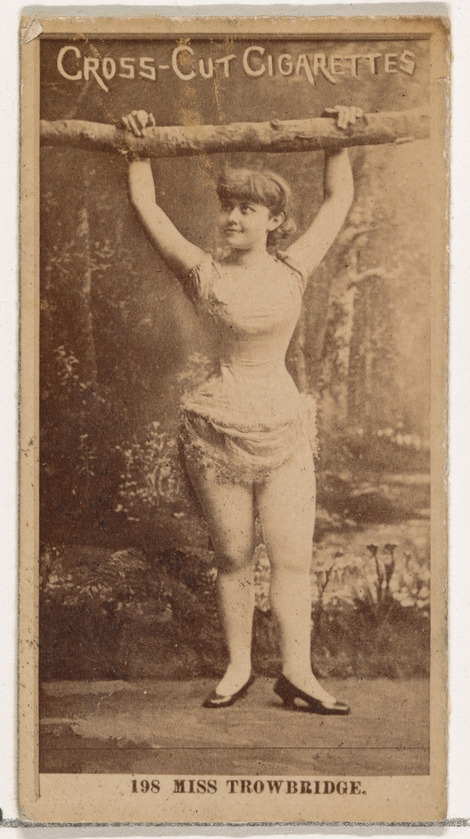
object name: print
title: Card Number 198, Miss Trowbridge, from the Actors and Actresses series (N145-2) issued by Duke Sons & Co. to promote Cross Cut Cigarettes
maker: w. duke, sons & co.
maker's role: publisher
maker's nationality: american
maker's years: 1870-1920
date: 1880-1889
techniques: albumen silver print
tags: portraits,women,actresses